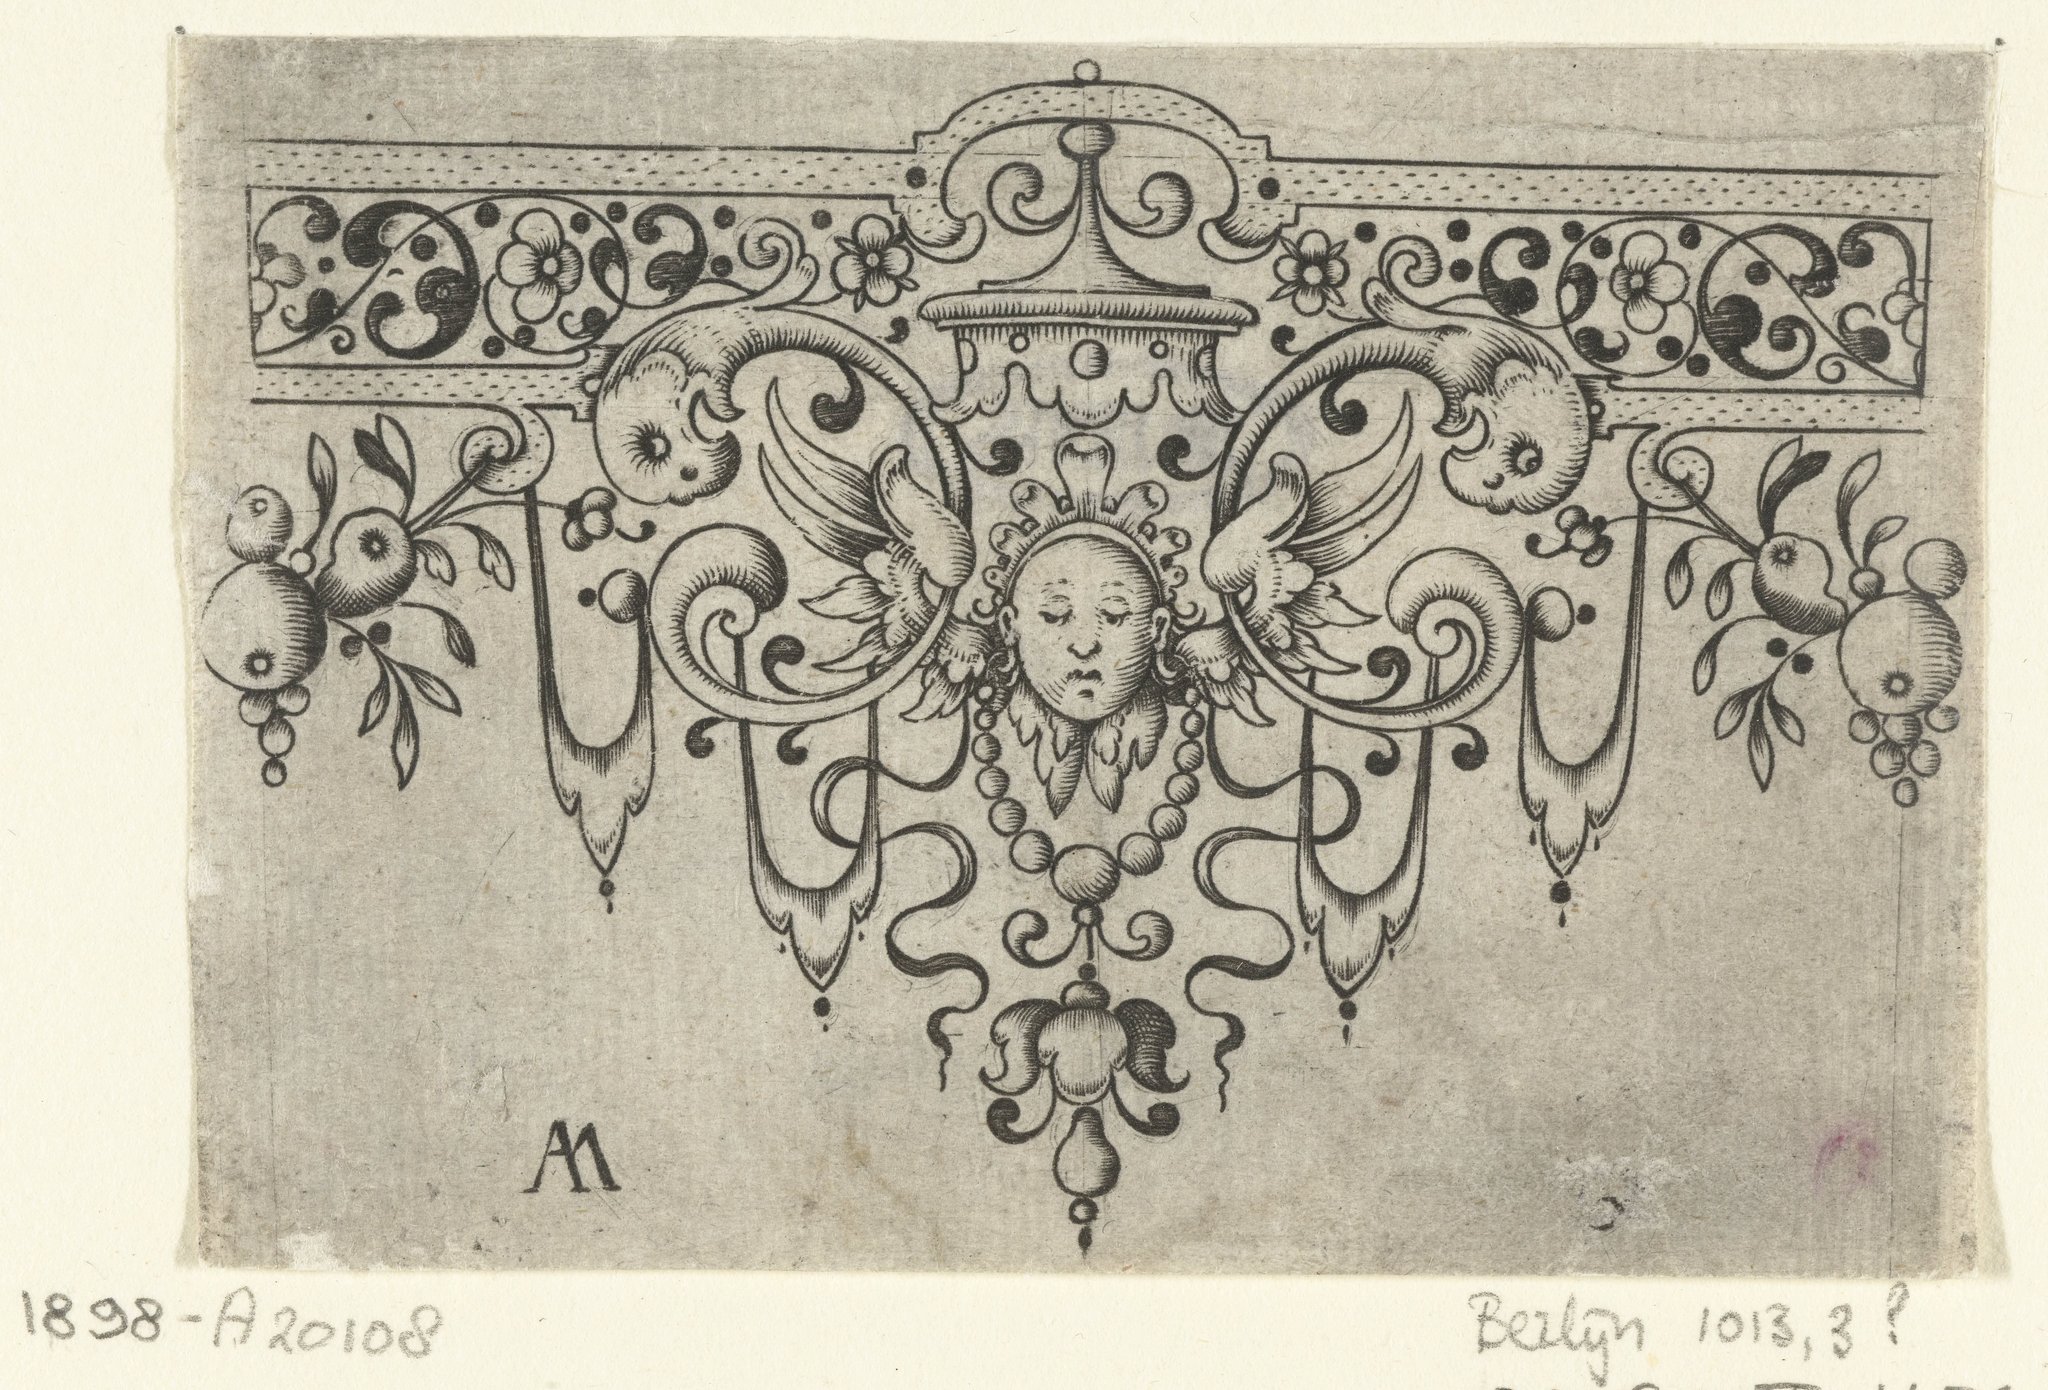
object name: ornament print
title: Spitsen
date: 1610-1611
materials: paper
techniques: engraving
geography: groningen